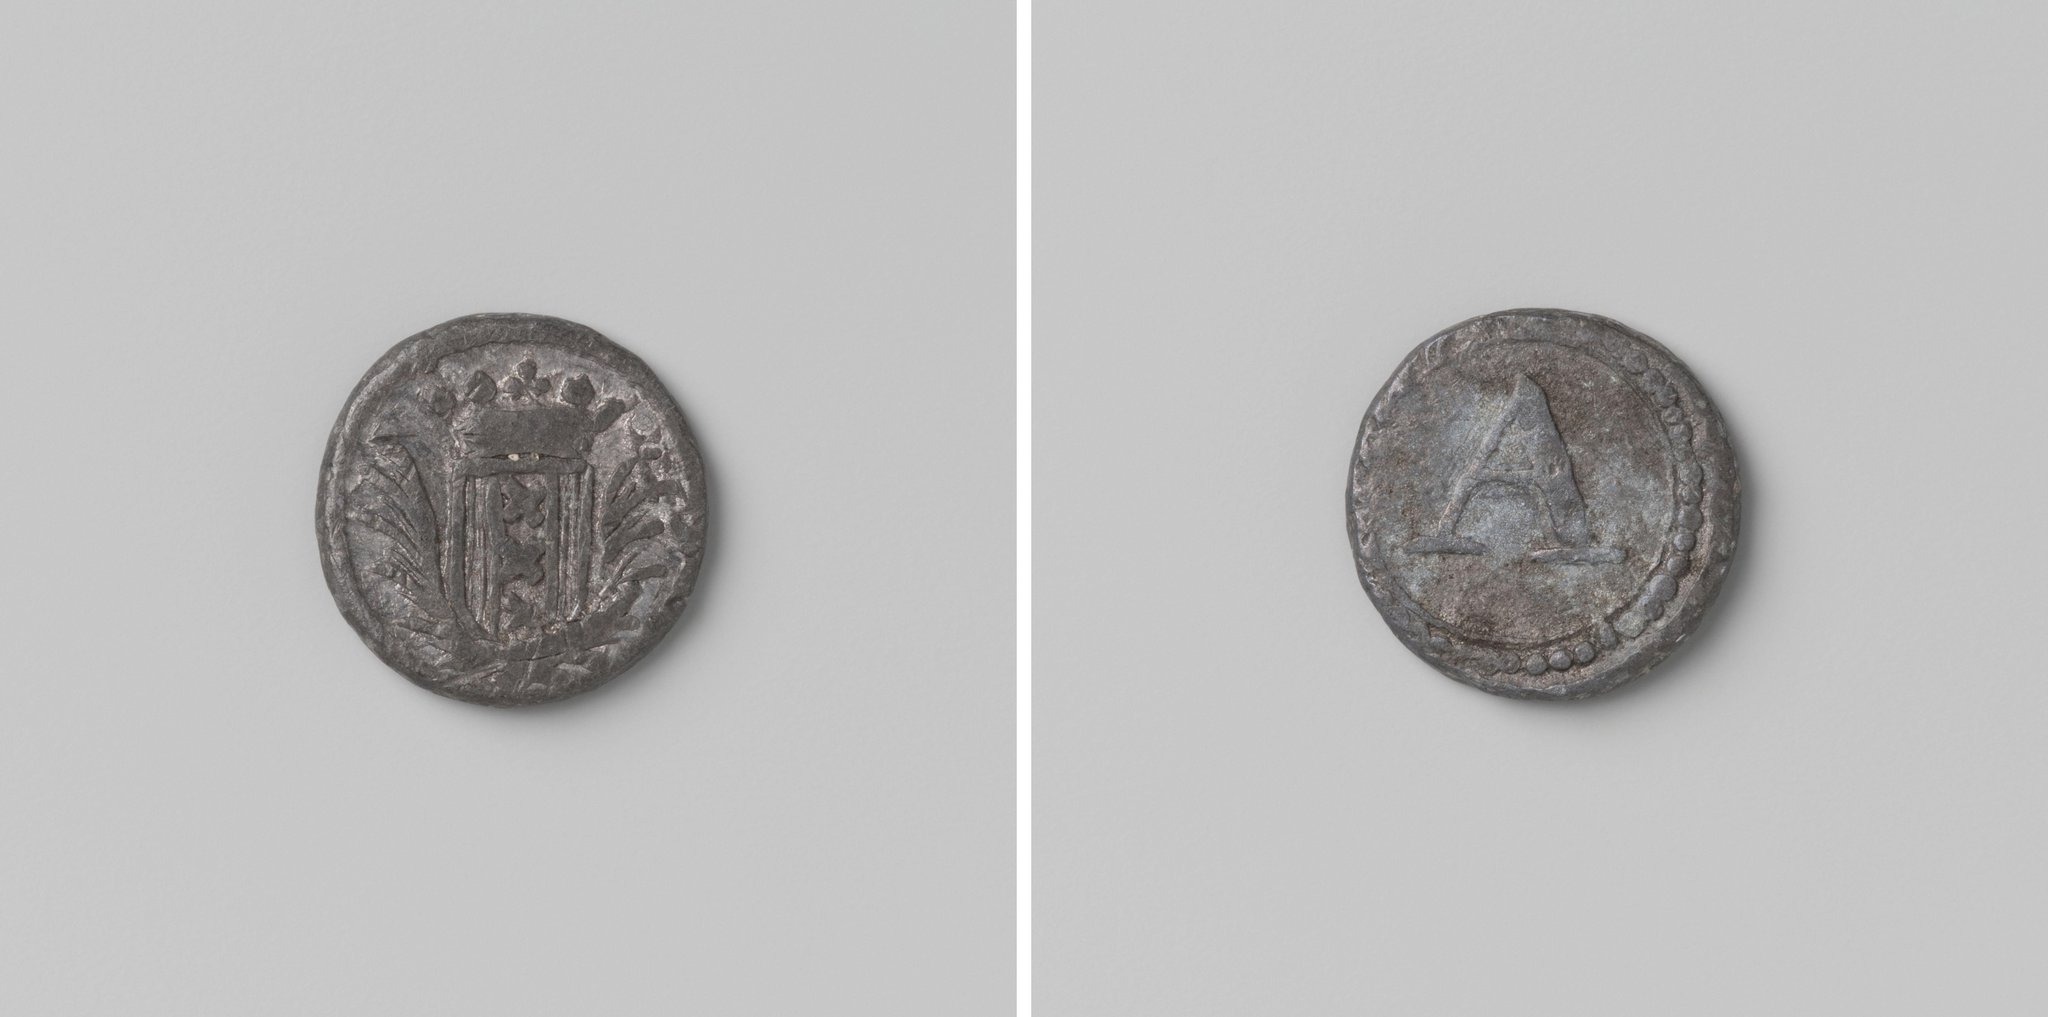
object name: loden penning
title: Armenpenning met letter A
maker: Anonymous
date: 1650-1800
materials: lead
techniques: casting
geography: amsterdam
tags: amsterdam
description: Loden penning. Voorzijde: gekroond wapenschild van Amsterdam, rustend op twee palmtakken. Keerzijde: letter A in parelrand.